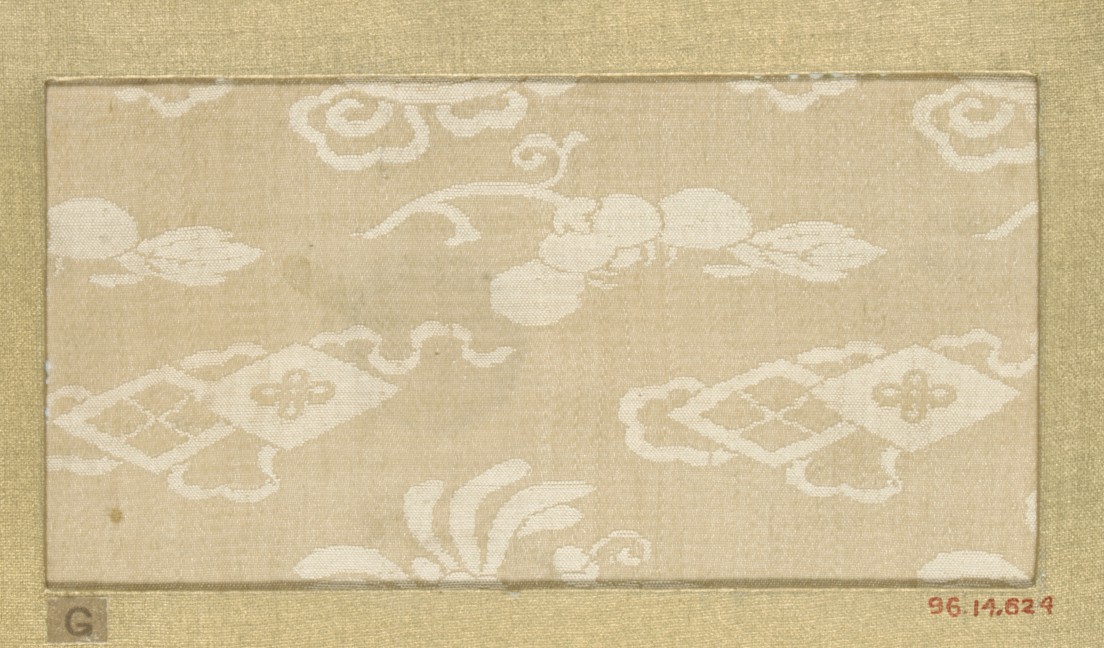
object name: piece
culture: japanese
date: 1701-1900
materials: silk